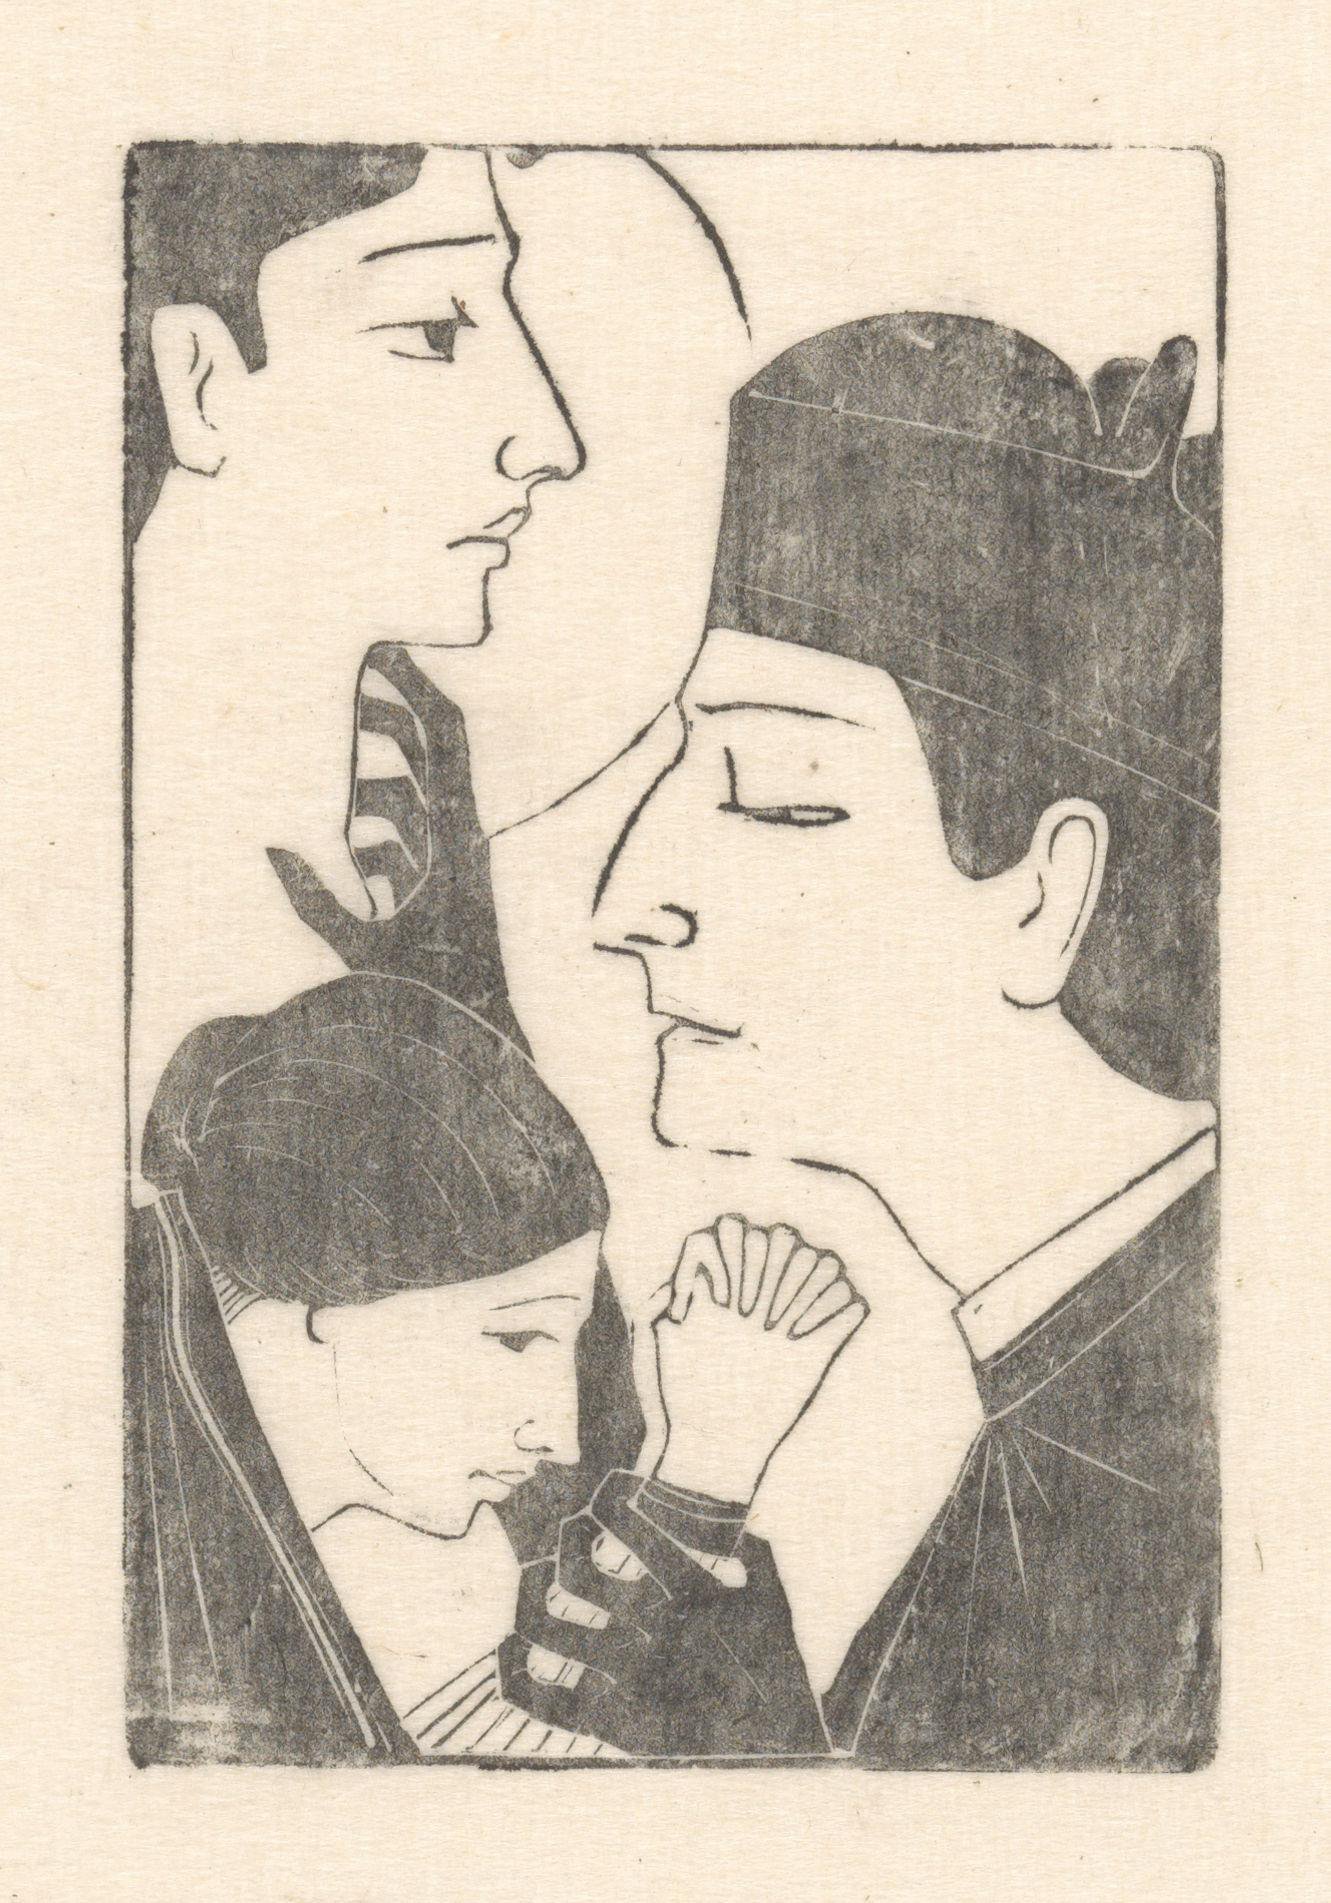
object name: illustration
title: Geestelijke met vrouw en jongeling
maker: karel petrus cornelis de bazel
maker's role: draughtsman, print maker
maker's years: 1869-1923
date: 1895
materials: paper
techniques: woodcut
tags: nimbus, halo ~ radiance emanating from persons or things, organization, functionaries and dignitaries in churches and in related institutions, postures and gestures of arms and hands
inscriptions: collector's mark: Lugt 2228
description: Een geestelijke die met zijn linkerhand de polsen van een biddende vrouw omklemd en met zijn rechterhand de hals van een jongeling grijpt. De jongeling heeft een aureool rond zijn gezicht.